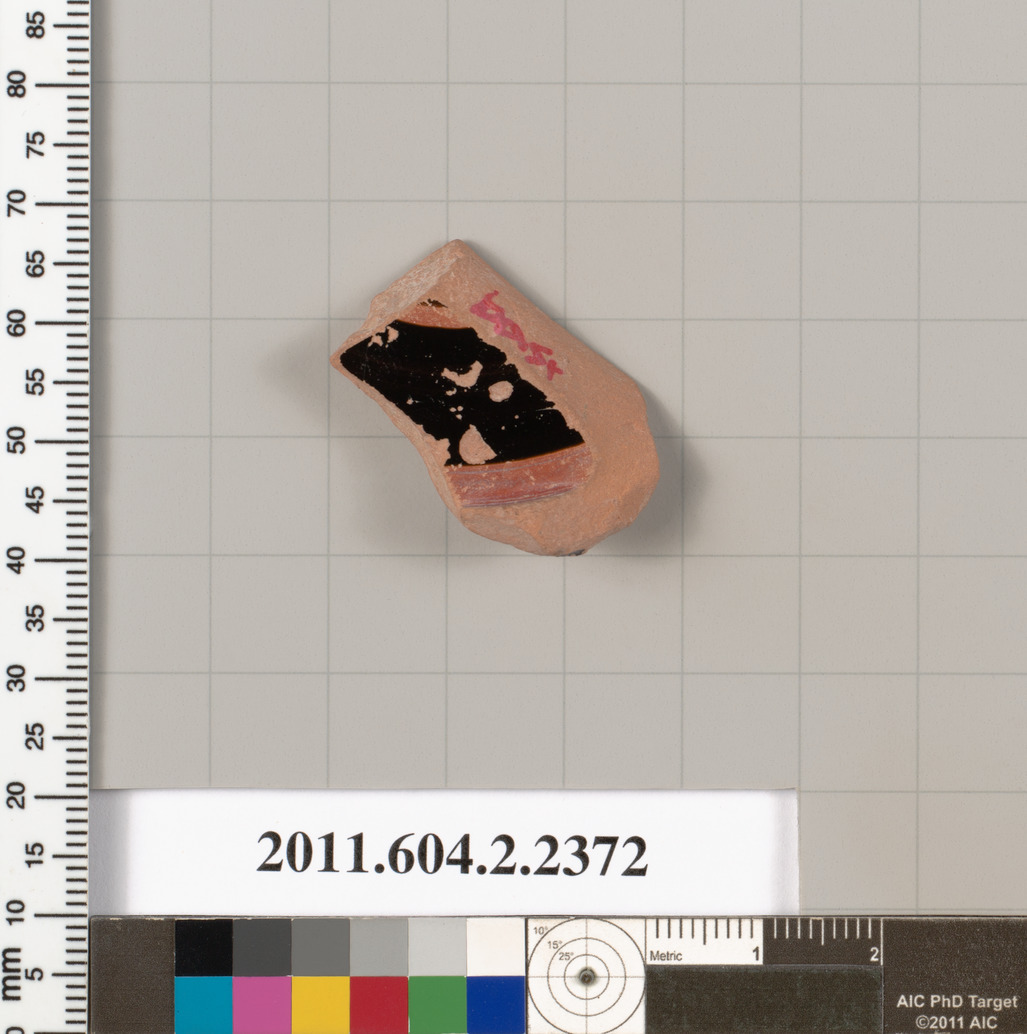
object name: plate or pyxis fragment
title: Terracotta fragment of a plate or a pyxis (box)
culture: greek, attic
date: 475-451 BCE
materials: terracotta